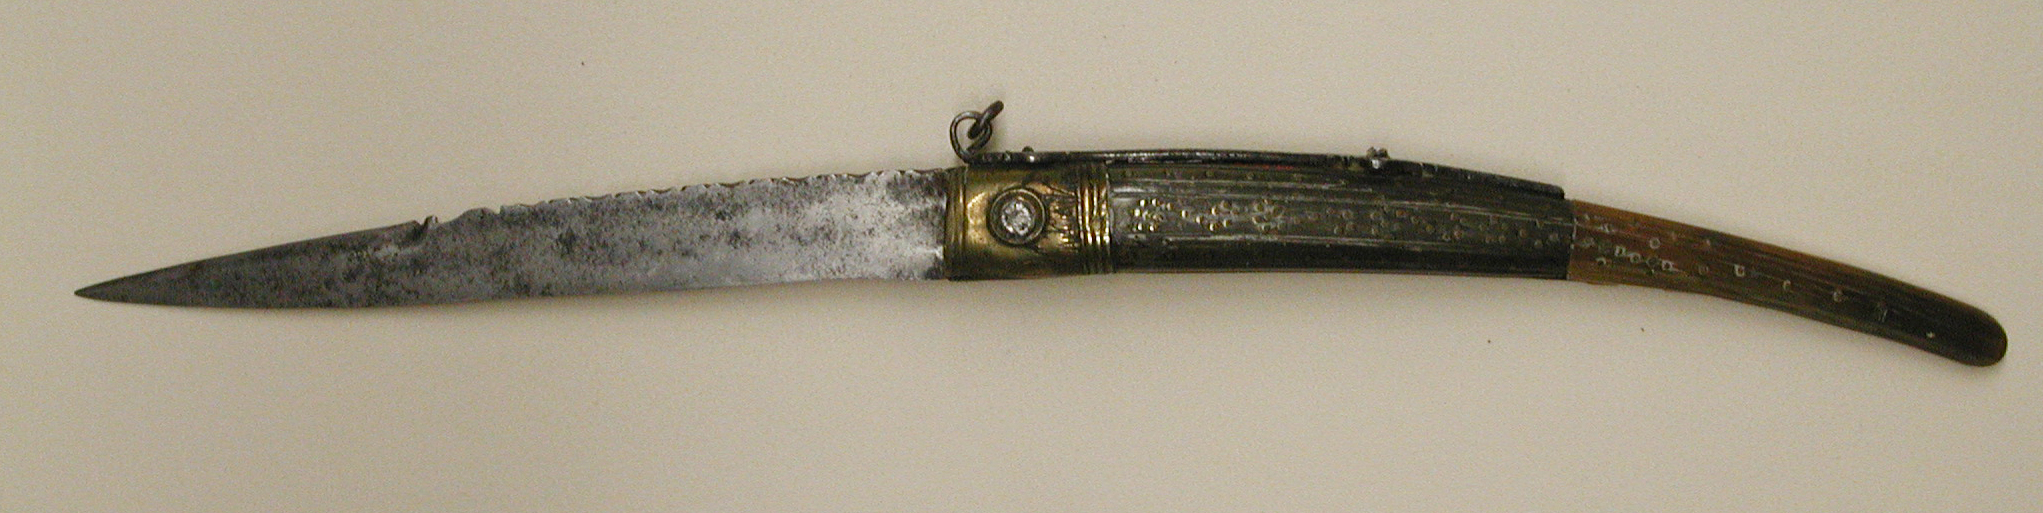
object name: clasp knife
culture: spanish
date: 1701-1800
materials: brass, horn, steel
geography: spain